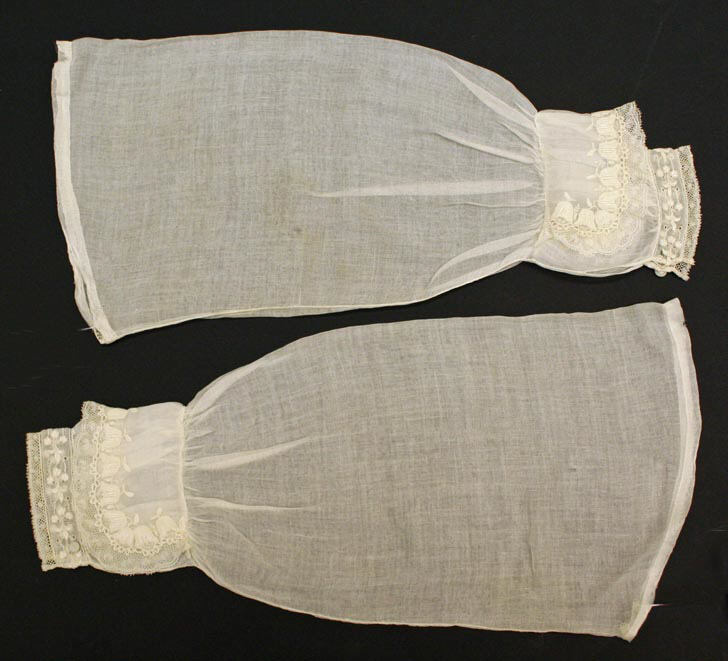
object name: undersleeves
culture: american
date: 1860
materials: cotton